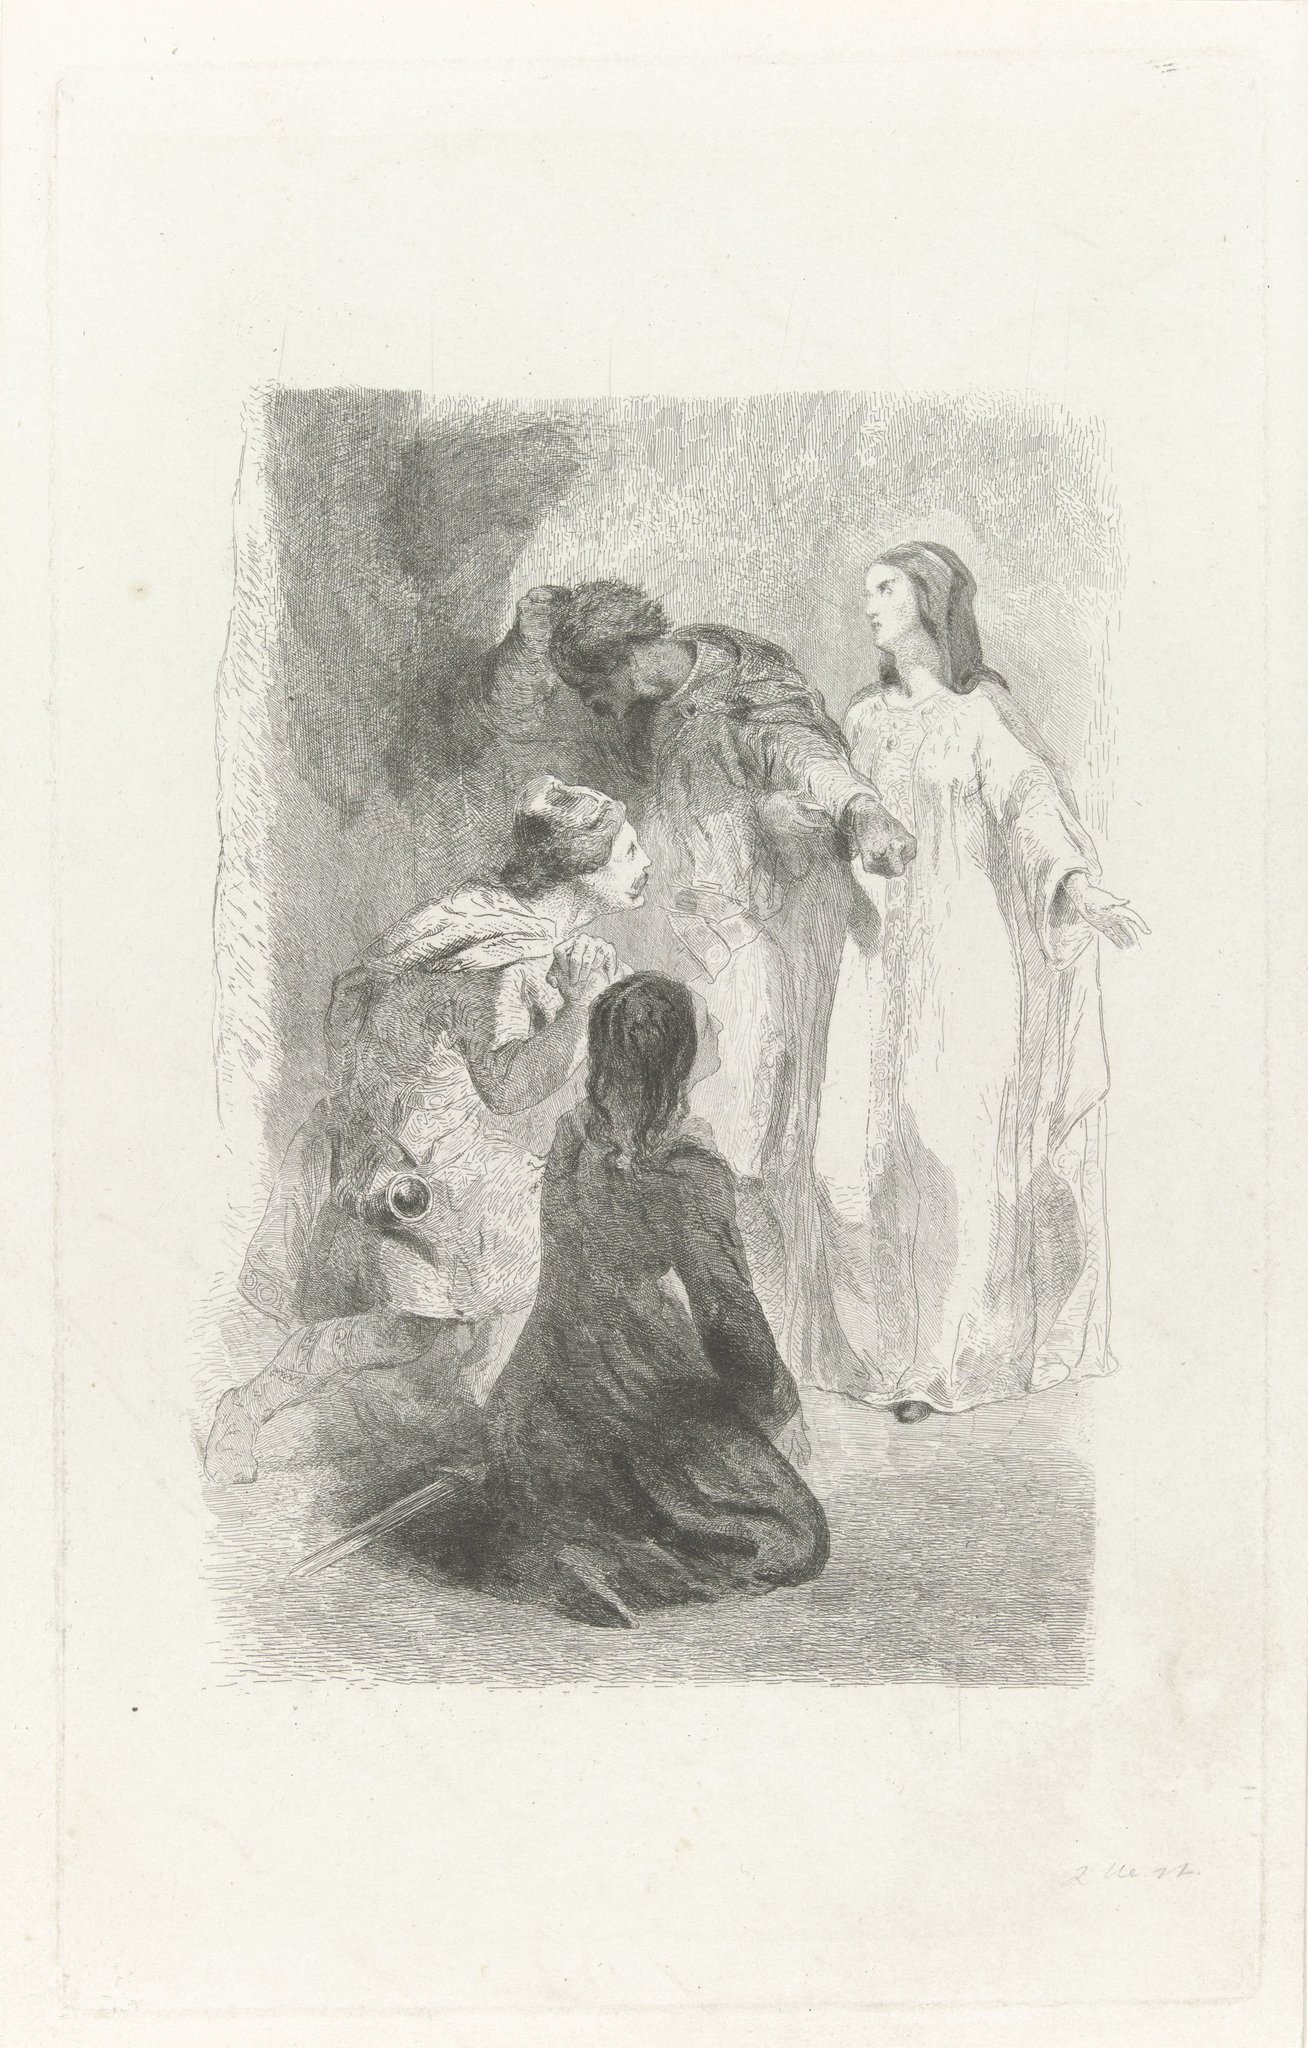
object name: print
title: Helene, Wilfried en zijn moeder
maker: charles rochussen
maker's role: draughtsman, painter, print maker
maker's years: 1814-1894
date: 1854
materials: paper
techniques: steel etching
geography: amsterdam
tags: one person praying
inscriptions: collector's mark: Lugt 2228, inscription: ‘2de st’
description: Helene, Wilfried, zijn moeder en een vierde persoon zijn bijeen gekomen en bidden. Illustratie van een scène uit een boek met gedichten genaamd 'Helene'.